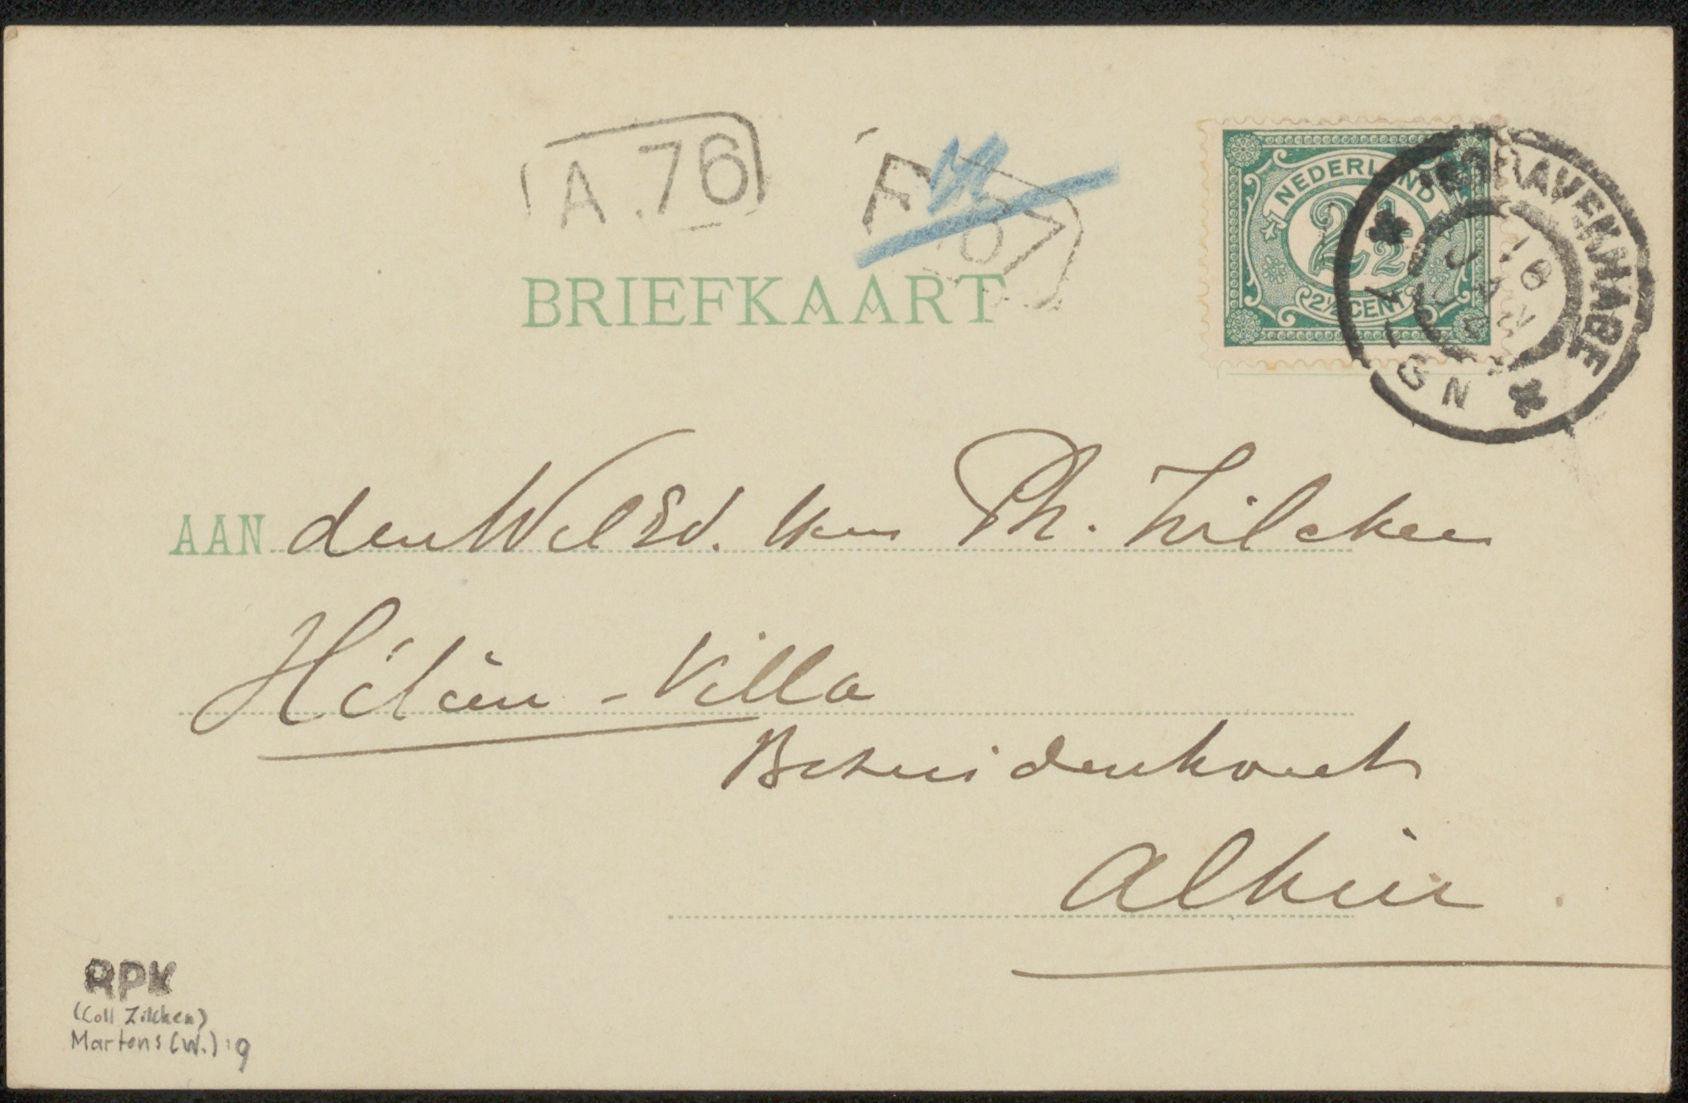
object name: postcard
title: Briefkaart aan Philip Zilcken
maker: willy martens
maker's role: painter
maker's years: 1856-1927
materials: cardboard, ink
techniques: pen, writing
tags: draughtsman, philip zilcken, exhibition ~ art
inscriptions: collector's mark: ‘RPK’